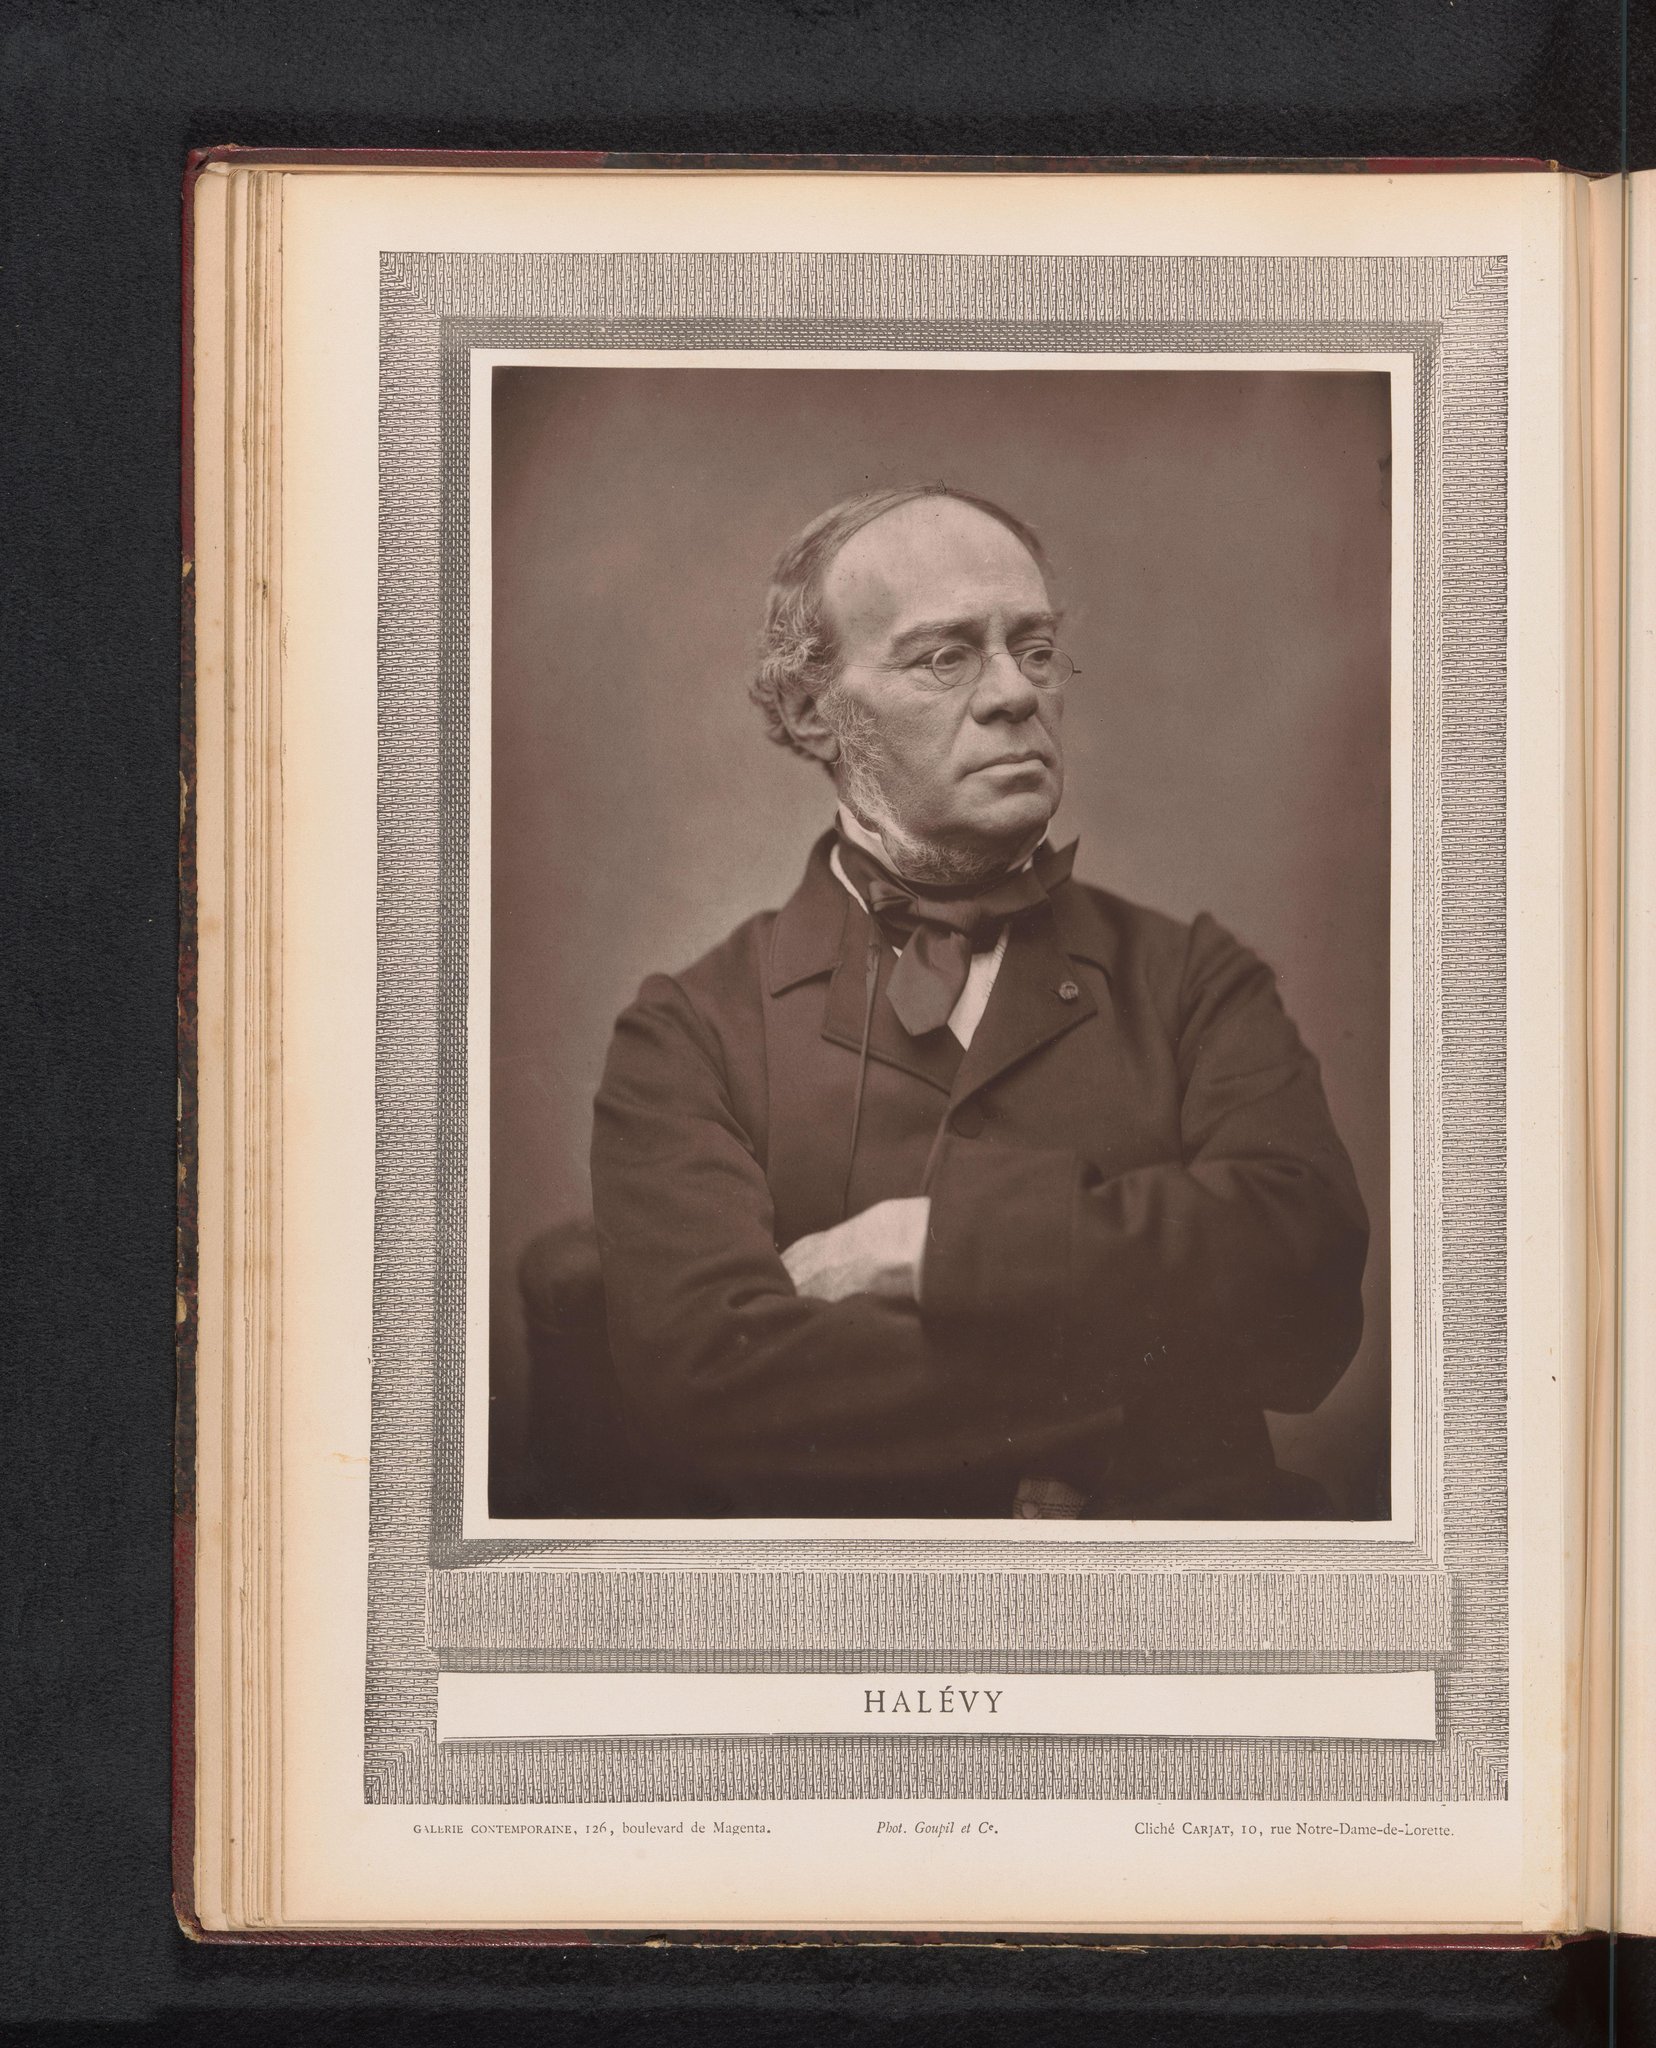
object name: photomechanical print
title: Portret van Jacques Fromental Halévy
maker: étienne carjat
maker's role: draughtsman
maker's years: 1828-1906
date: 1871-1877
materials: paper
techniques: woodburytype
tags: paris, adult man, historical persons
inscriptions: inscription: ‘Galerie Contemporaine, 126, boulevard de Magenta.’